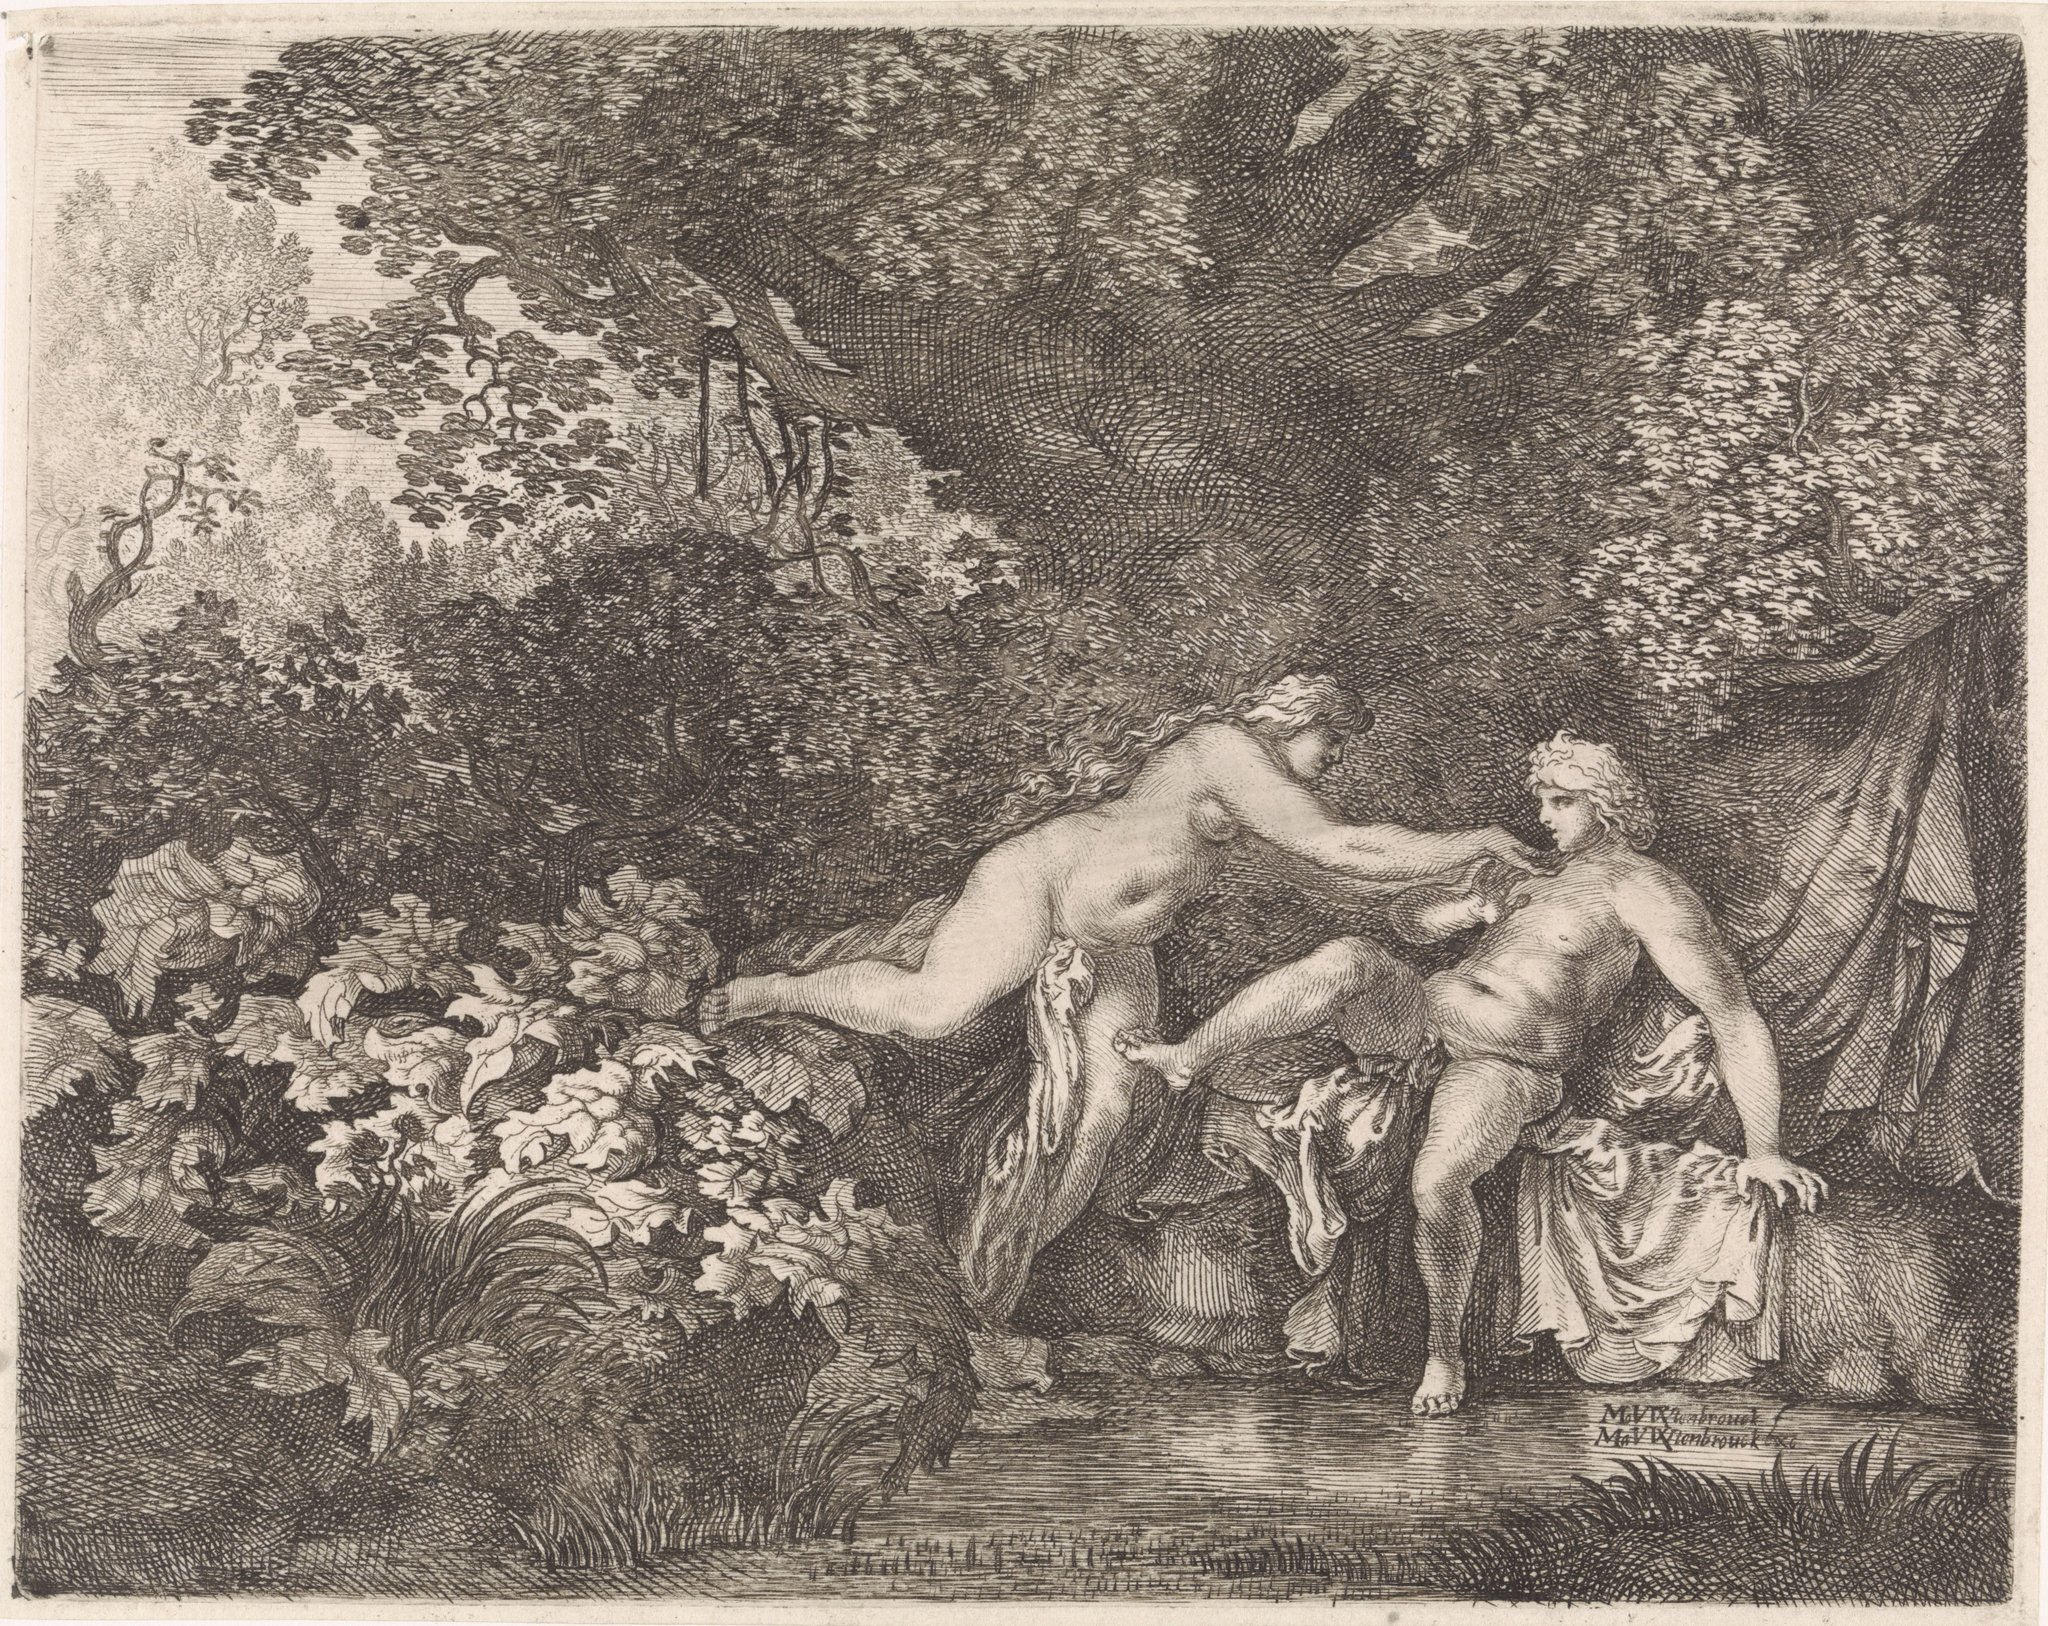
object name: print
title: Salmacis en Hermaphroditus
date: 1600-1647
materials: paper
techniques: engraving, etching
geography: antwerp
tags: story of hermaphroditus and salmacis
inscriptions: collector's mark: Lugt 2228, collector's mark: Lugt 2610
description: De nimf Salmacis reikt naar Hermaphroditus, die haar probeert af te weren, voordat zij hem zou omhelzen en ze volgens de mythe zouden versmelten tot een tweeslachtig wezen. Ze zitten aan de rand van een bosmeer. Scène uit Ovidius’ Metamorfosen (Met. II, 341-357).